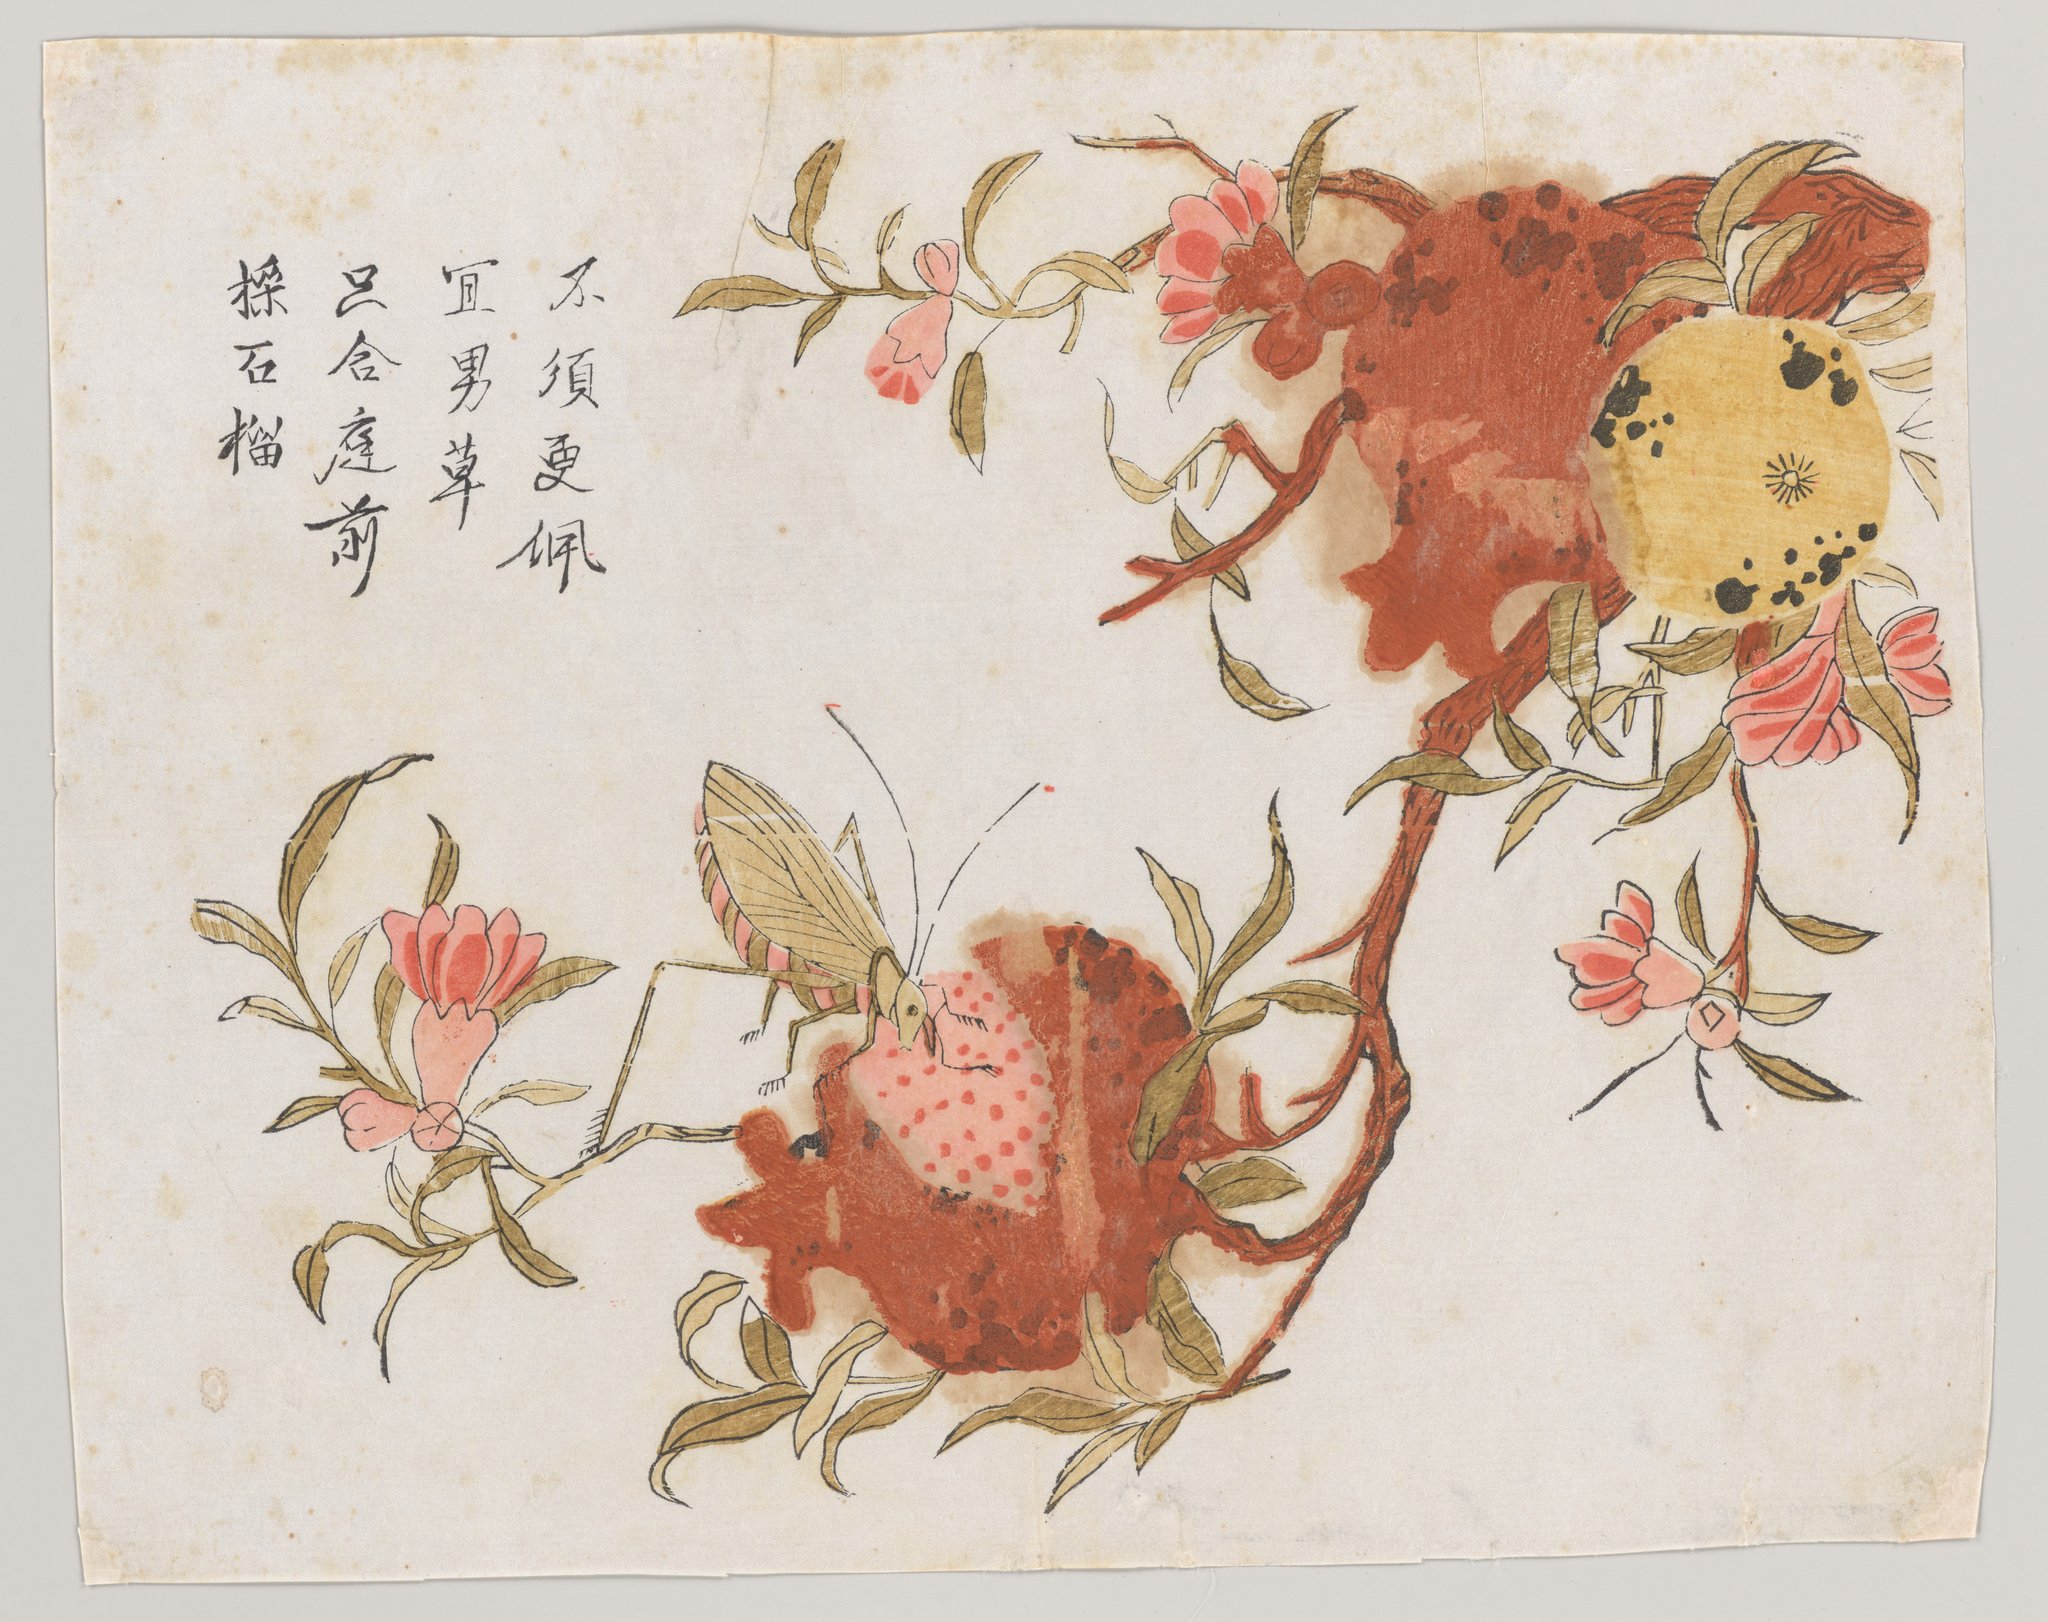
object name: print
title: Grasshopper on Pomegranate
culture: chinese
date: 1701-1800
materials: ink, paper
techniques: polychrome, woodblock print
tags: fruit,insects